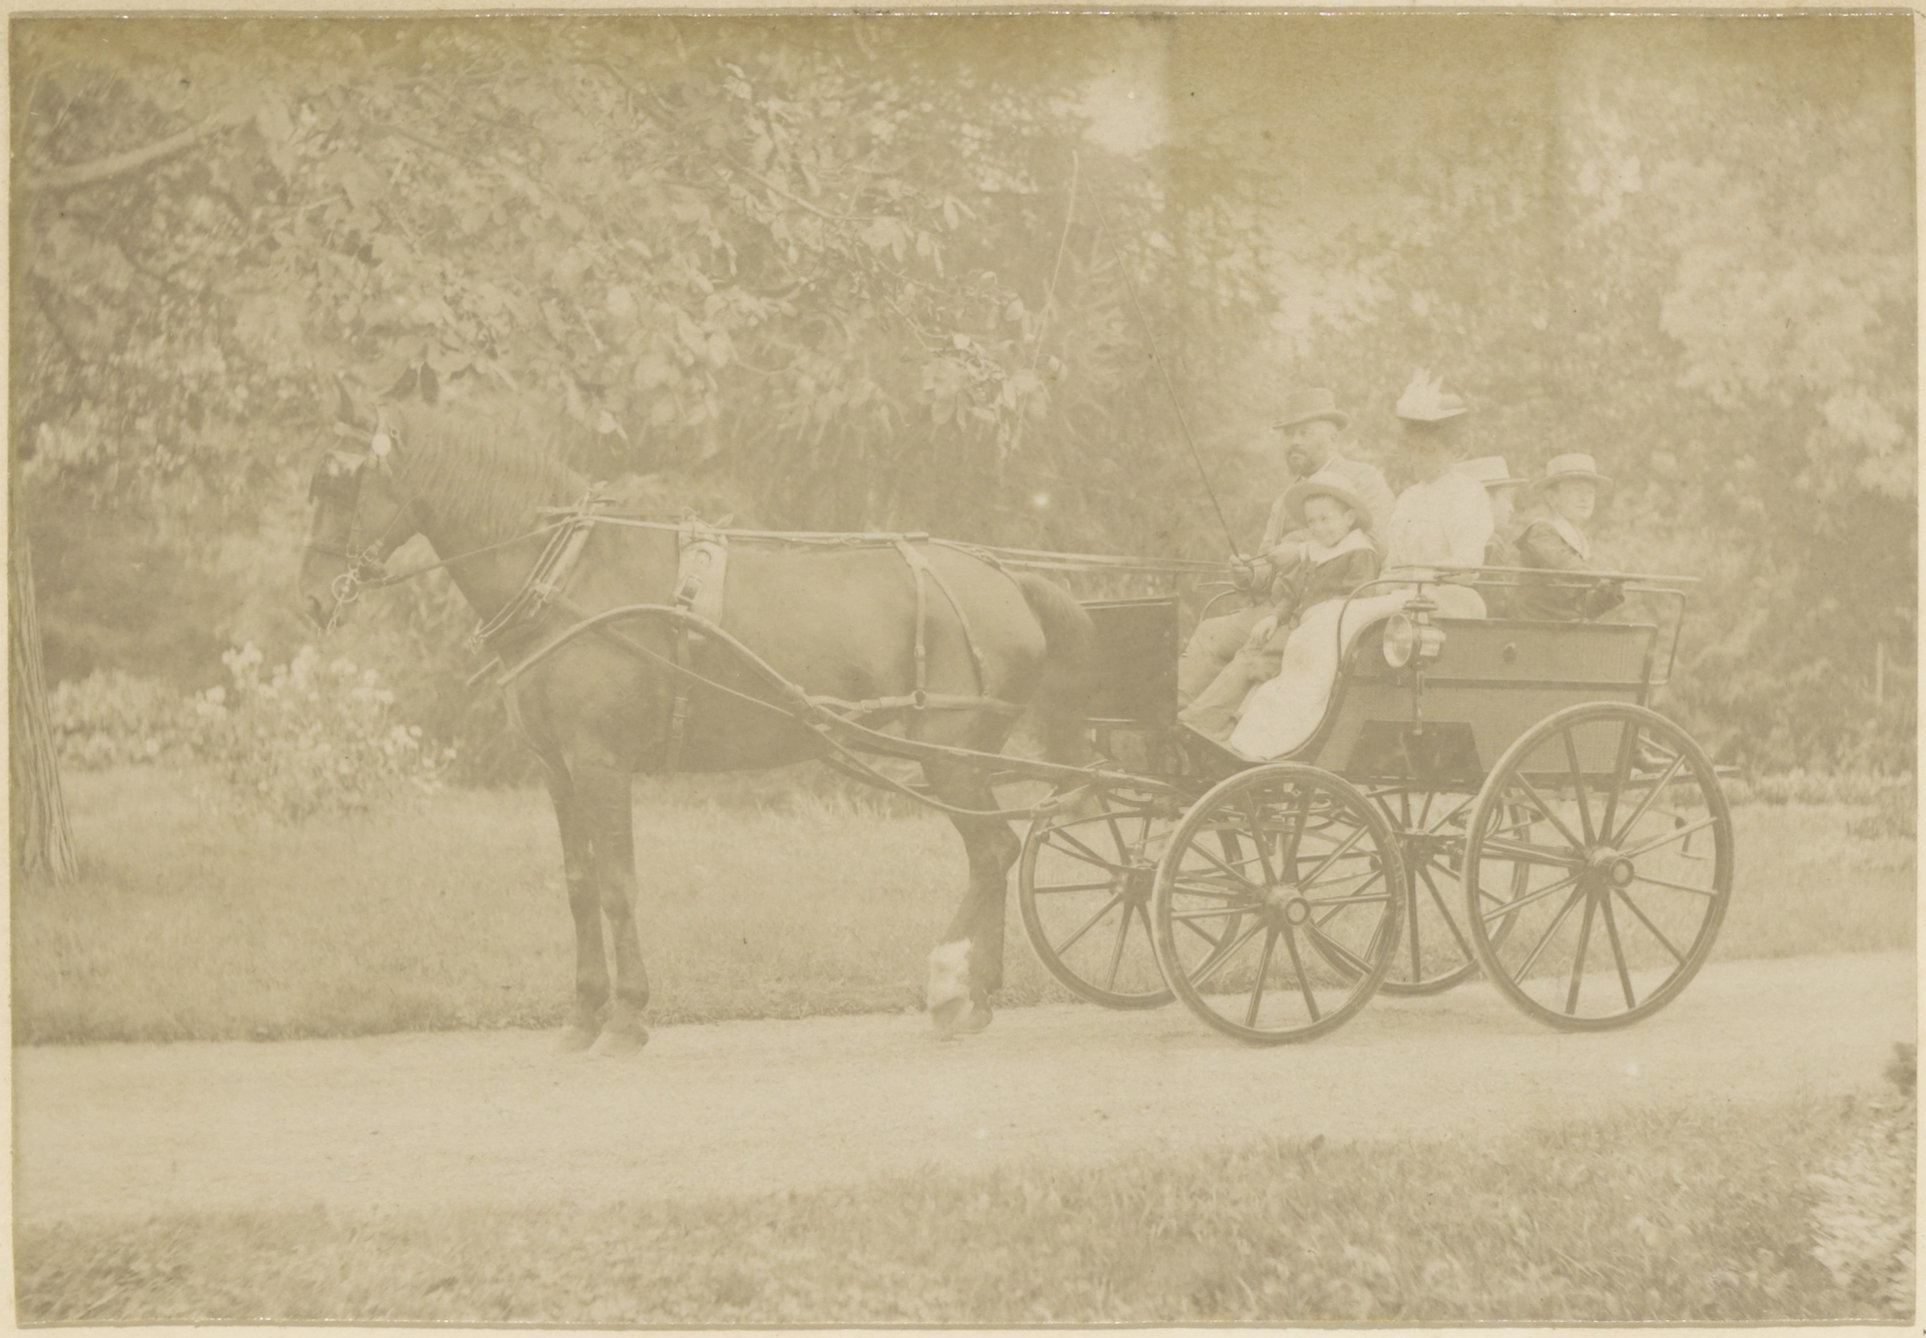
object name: photograph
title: Gezin in een rijtuig met paard in Frankrijk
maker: Anonymous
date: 1900-1910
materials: paper, photographic support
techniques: albumen print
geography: france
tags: parents with their children, four-wheeled, animal-drawn vehicle, e.g.: cab, carriage, coach, france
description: Onderdeel van Fotoalbum van een Franse amateurfotograaf met opnames van een familie, distilleerderij Delizy & Doistau Fils, het leger en bezienswaardigheden in Frankrijk.